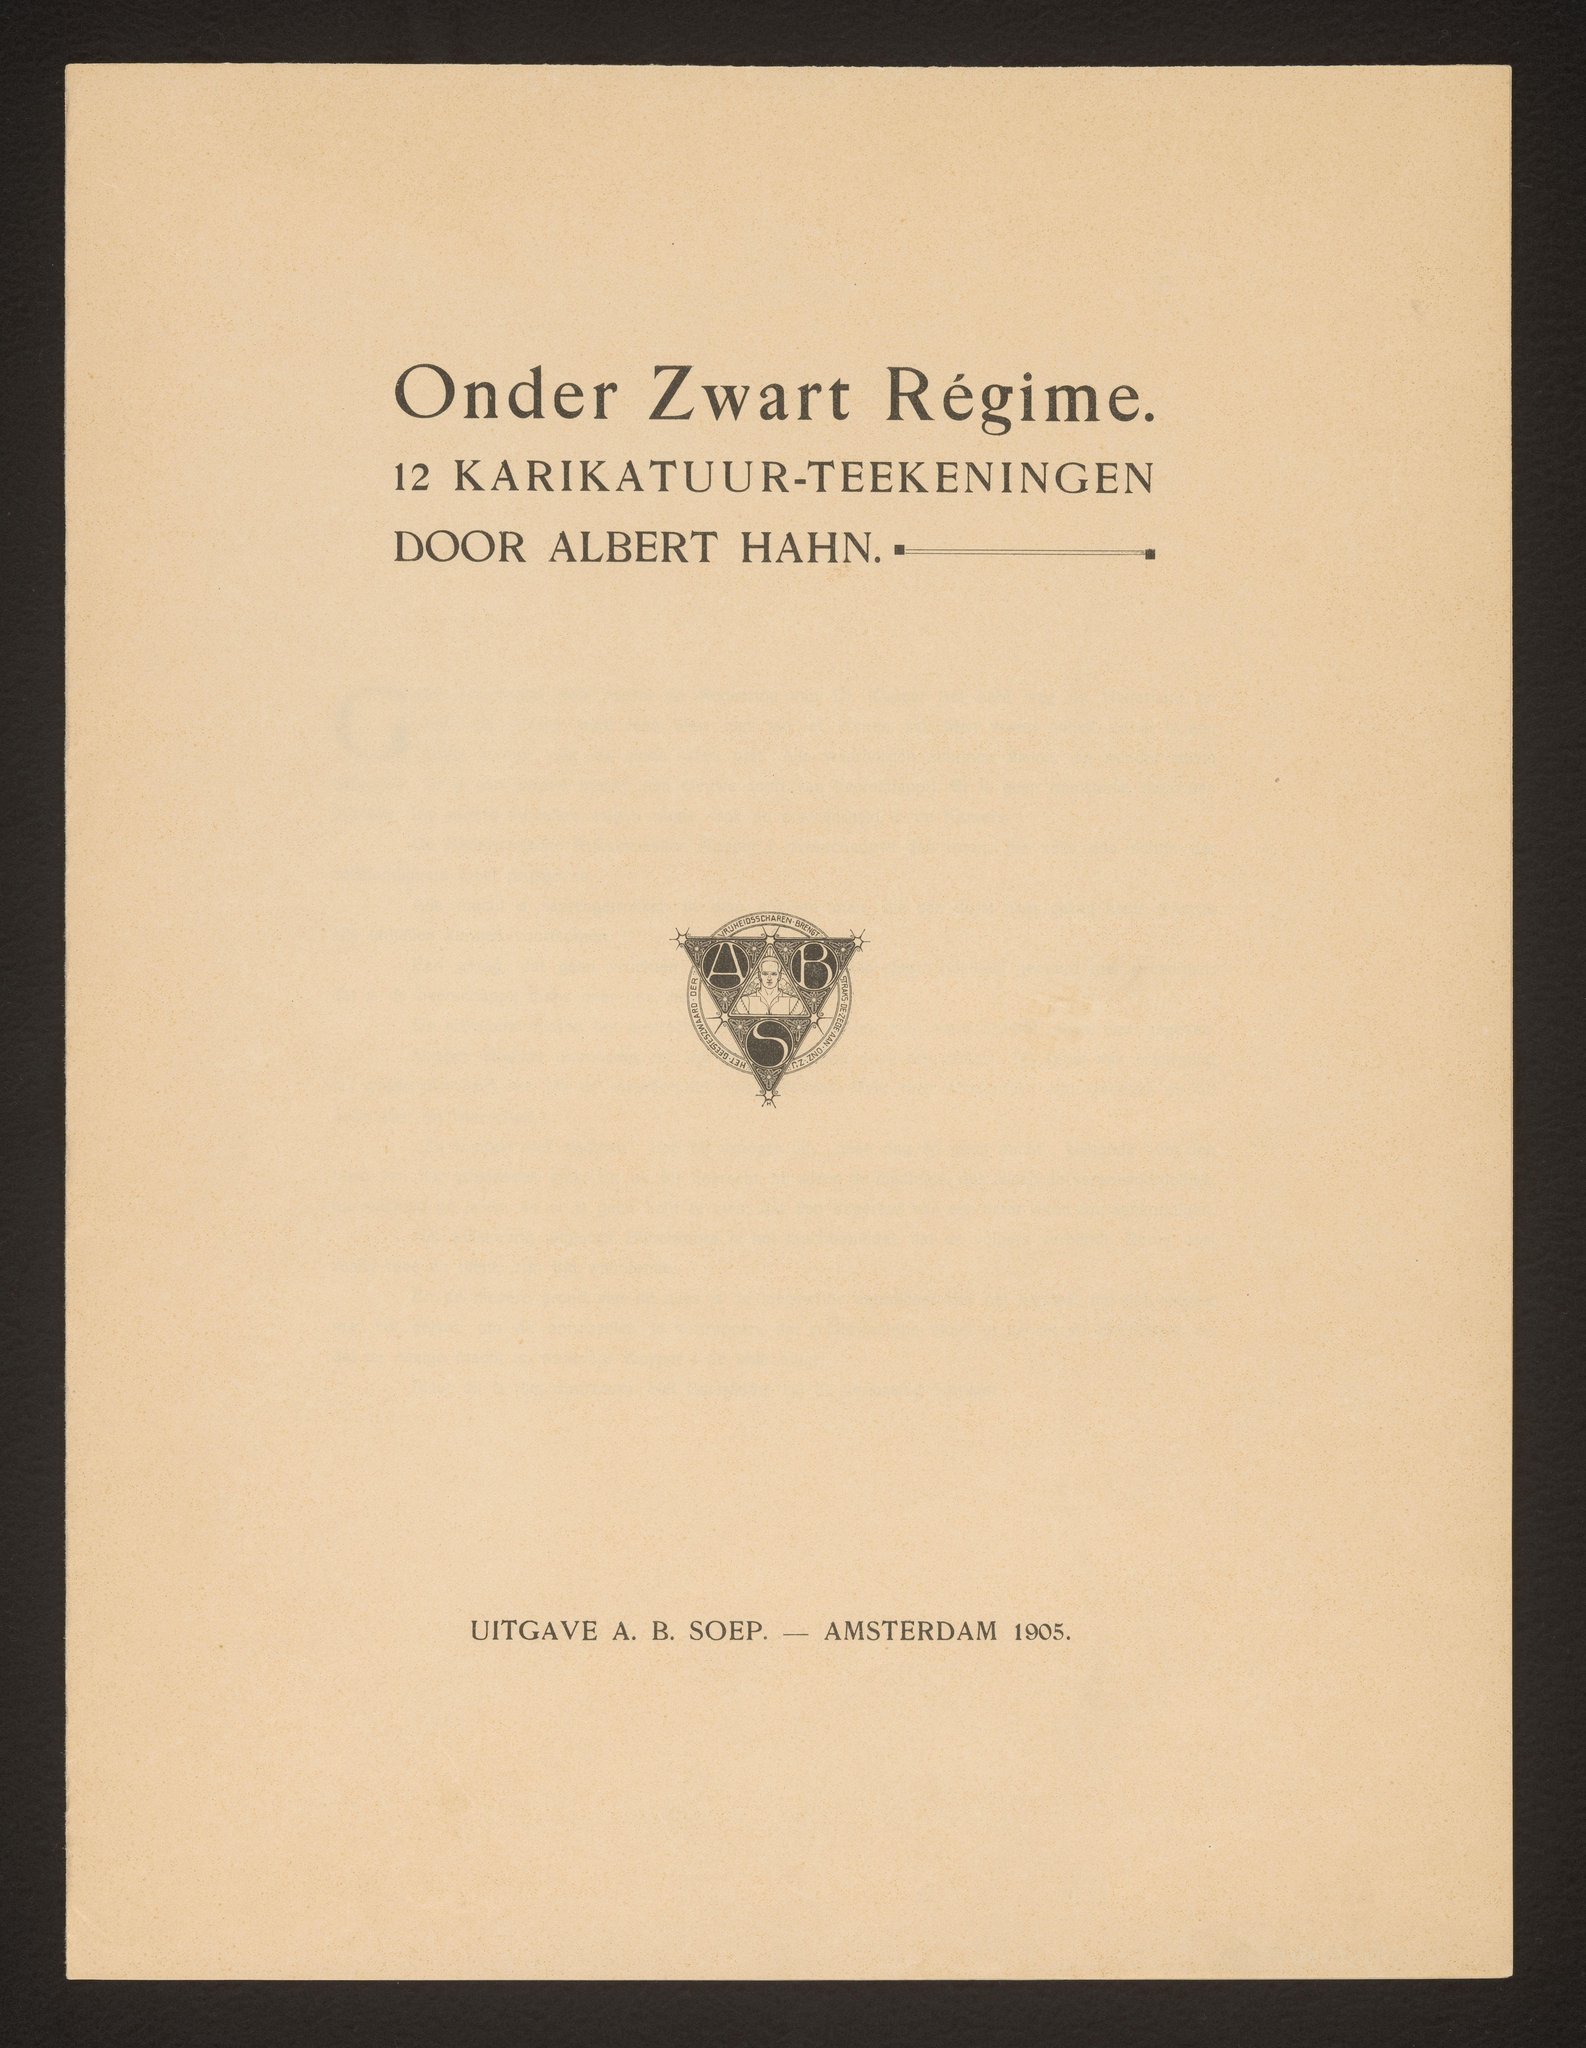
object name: print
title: Onder Zwart Régime. 12 Karikatuur-teekeningen door Albert Hahn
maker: a.b. soep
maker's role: publisher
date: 1905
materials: cardboard, paper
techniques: lithograph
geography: amsterdam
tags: the hague, abraham kuyper, political caricatures and satires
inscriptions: date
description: Papieren binnenmap met titel bevattende twaalf genummerde prenten, gekleurd, met elk een vierregelig onderschrift. Achterste blad van de binnenmap bevat een gedrukte tekst over 'de zwarte wolk ... van de Regeering van Dr. Kuyper' en 'Het socialisme zal de verlossing brengen'.